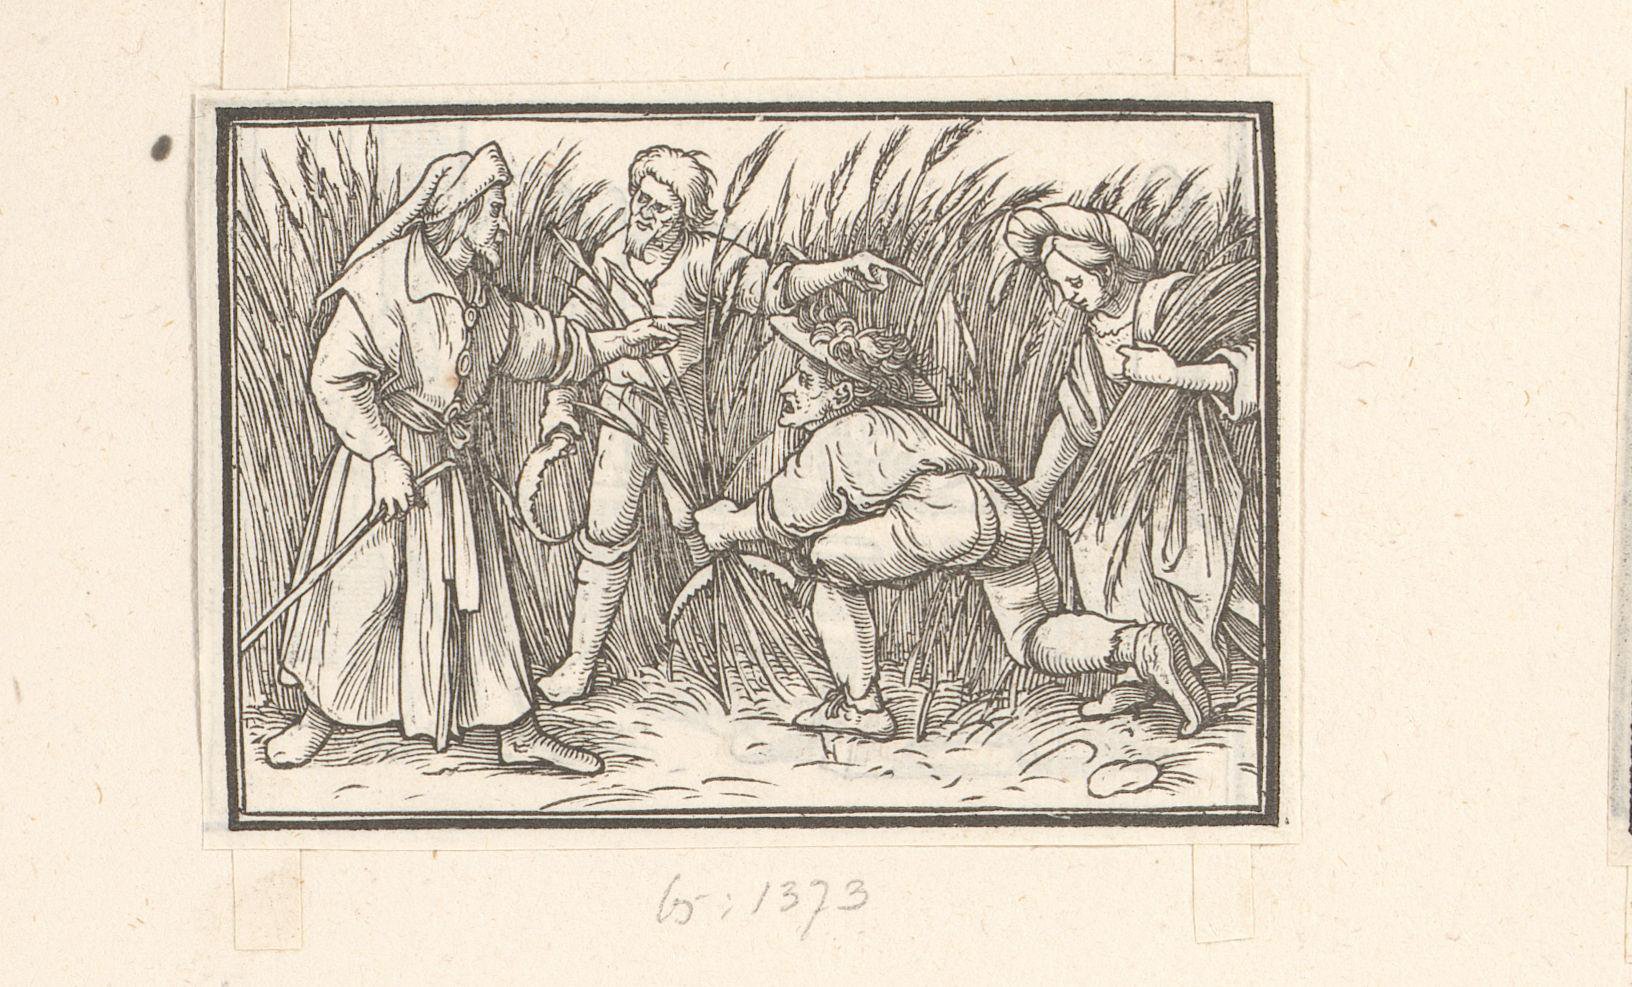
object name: book illustration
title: Geschiedenis van het Oude Testament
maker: veit rudolf specklin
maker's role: print maker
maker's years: -1550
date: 1538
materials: paper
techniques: woodcut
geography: switzerland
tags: ruth gleaning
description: Boekillustratie voor het eerst gebruikt in: Biblia Utriusque Testamenti iuxta Vulgatam Translationem, Lyon, M. en G. Trechsel (voor Hugo à Porta) 1538. Later in verschillende uitgaven opnieuw gebruikt. Deze prent vermoedelijk gebruikt in één van de uitgaven uitgegeven en/of gedrukt door Jean Frellon, Lyon.